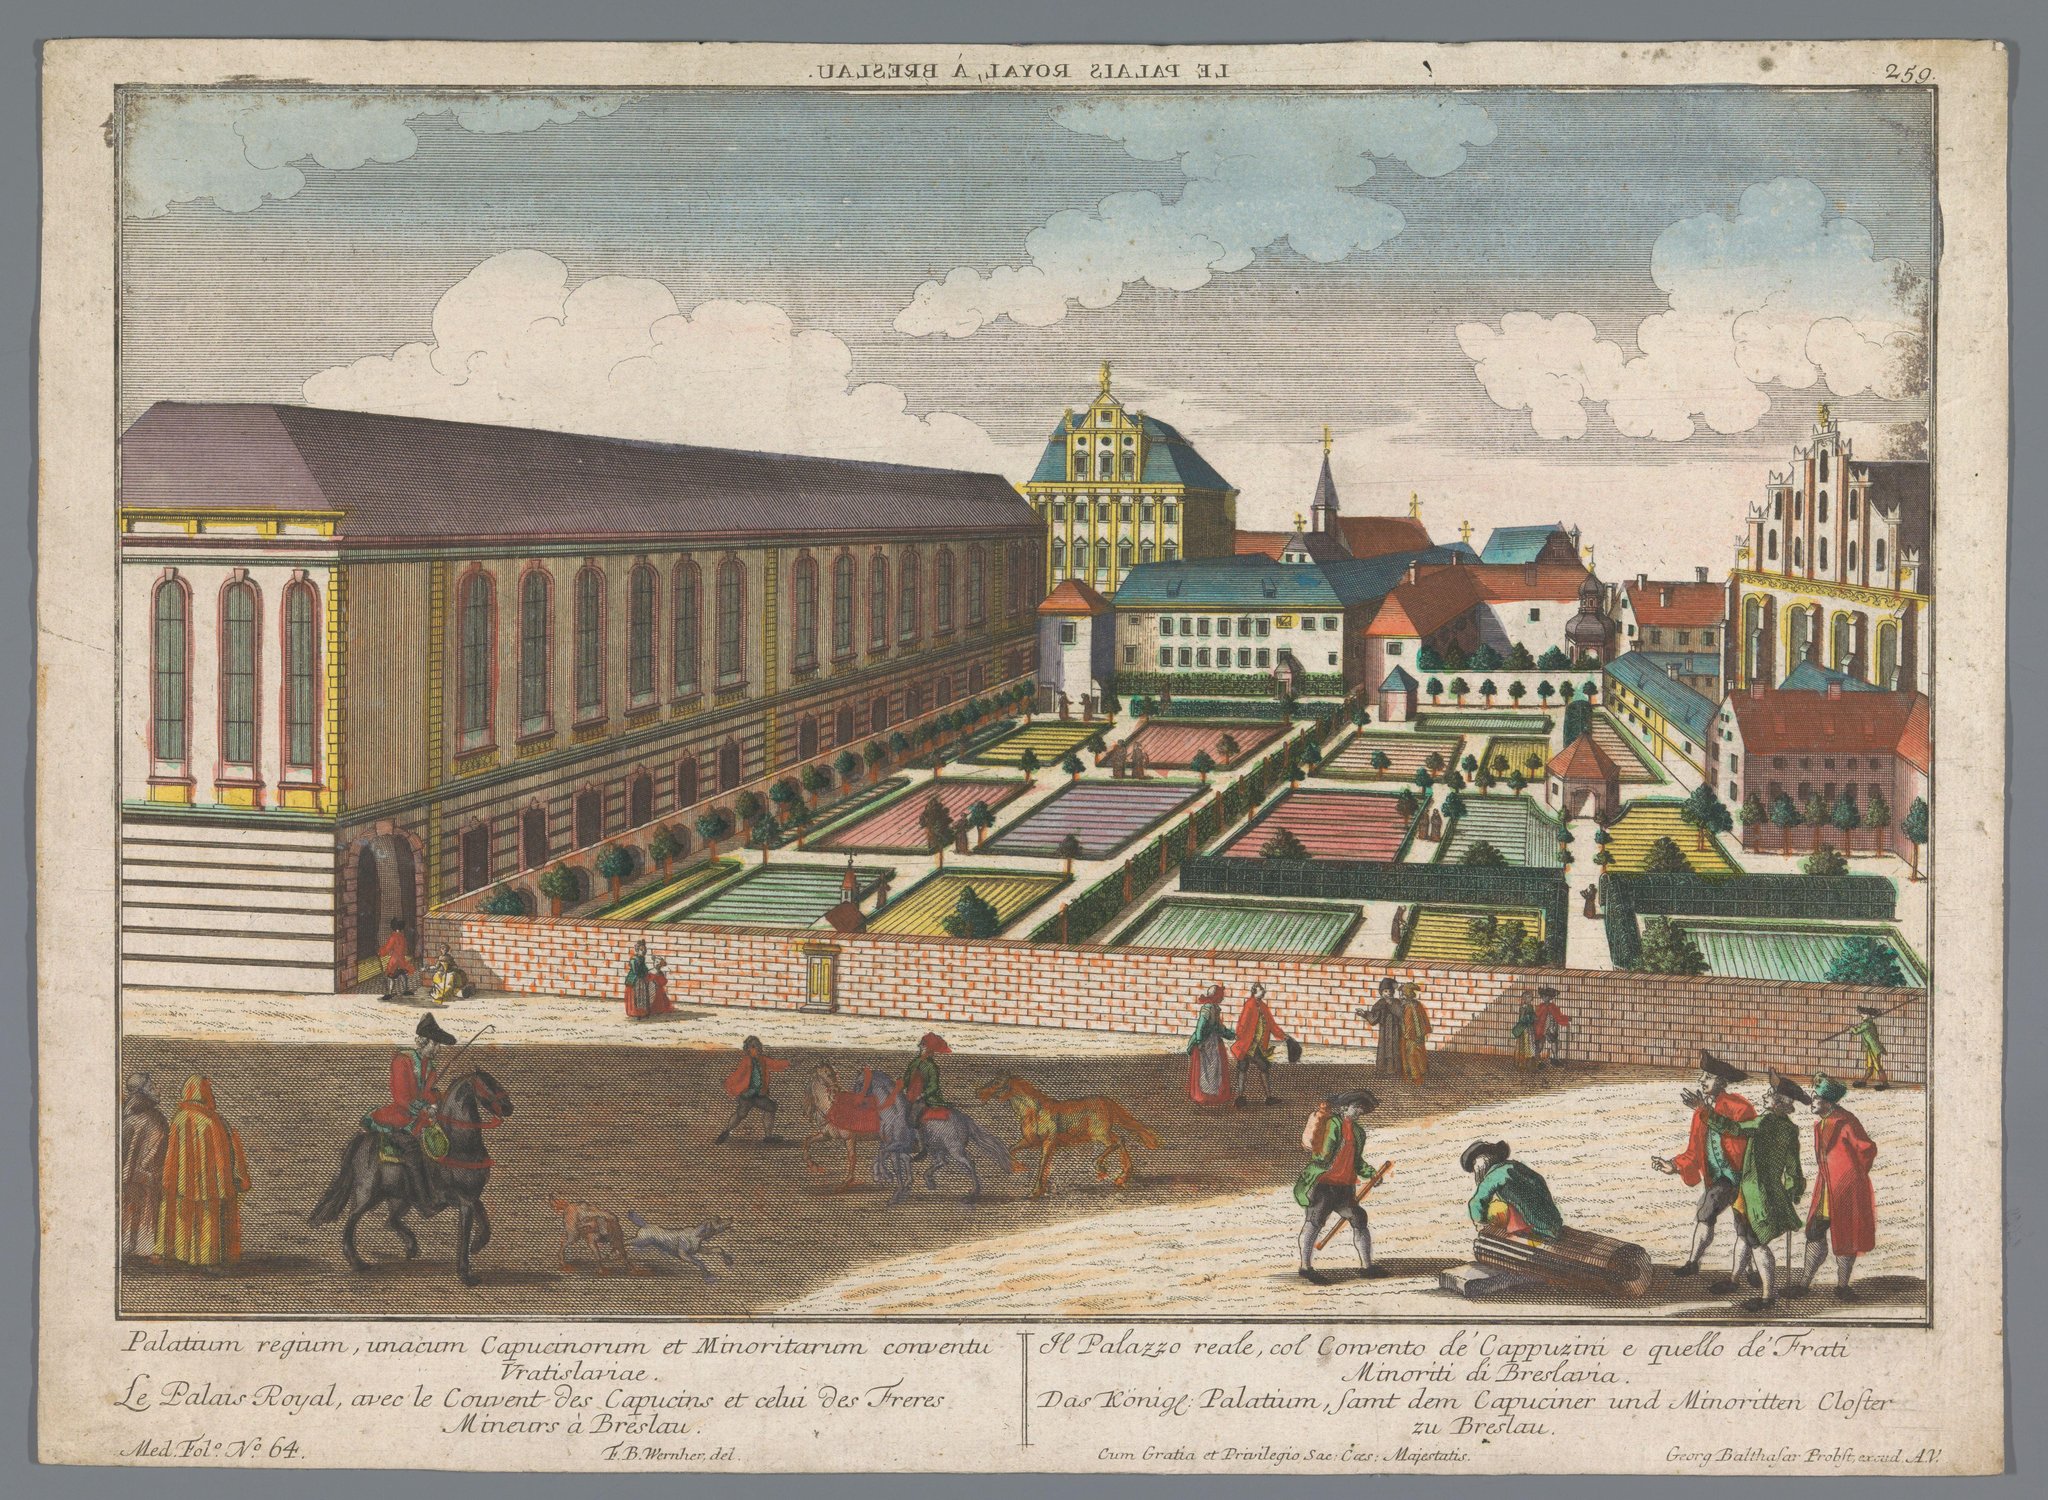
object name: print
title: Das Könige Palatium, samt dem Capuciner und Minoritten Closter zu Breslau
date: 1742-1801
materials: cardboard, paper, watercolor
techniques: brush, etching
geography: germany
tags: abbey, monastery, convent ~ roman catholic church, palace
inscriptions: collector's mark: Lugt 2233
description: De serie “Wroclaw”, met het nummer 64, bevat vier prenten met de nummers 258-261, waarvan dit nummer 259 is.